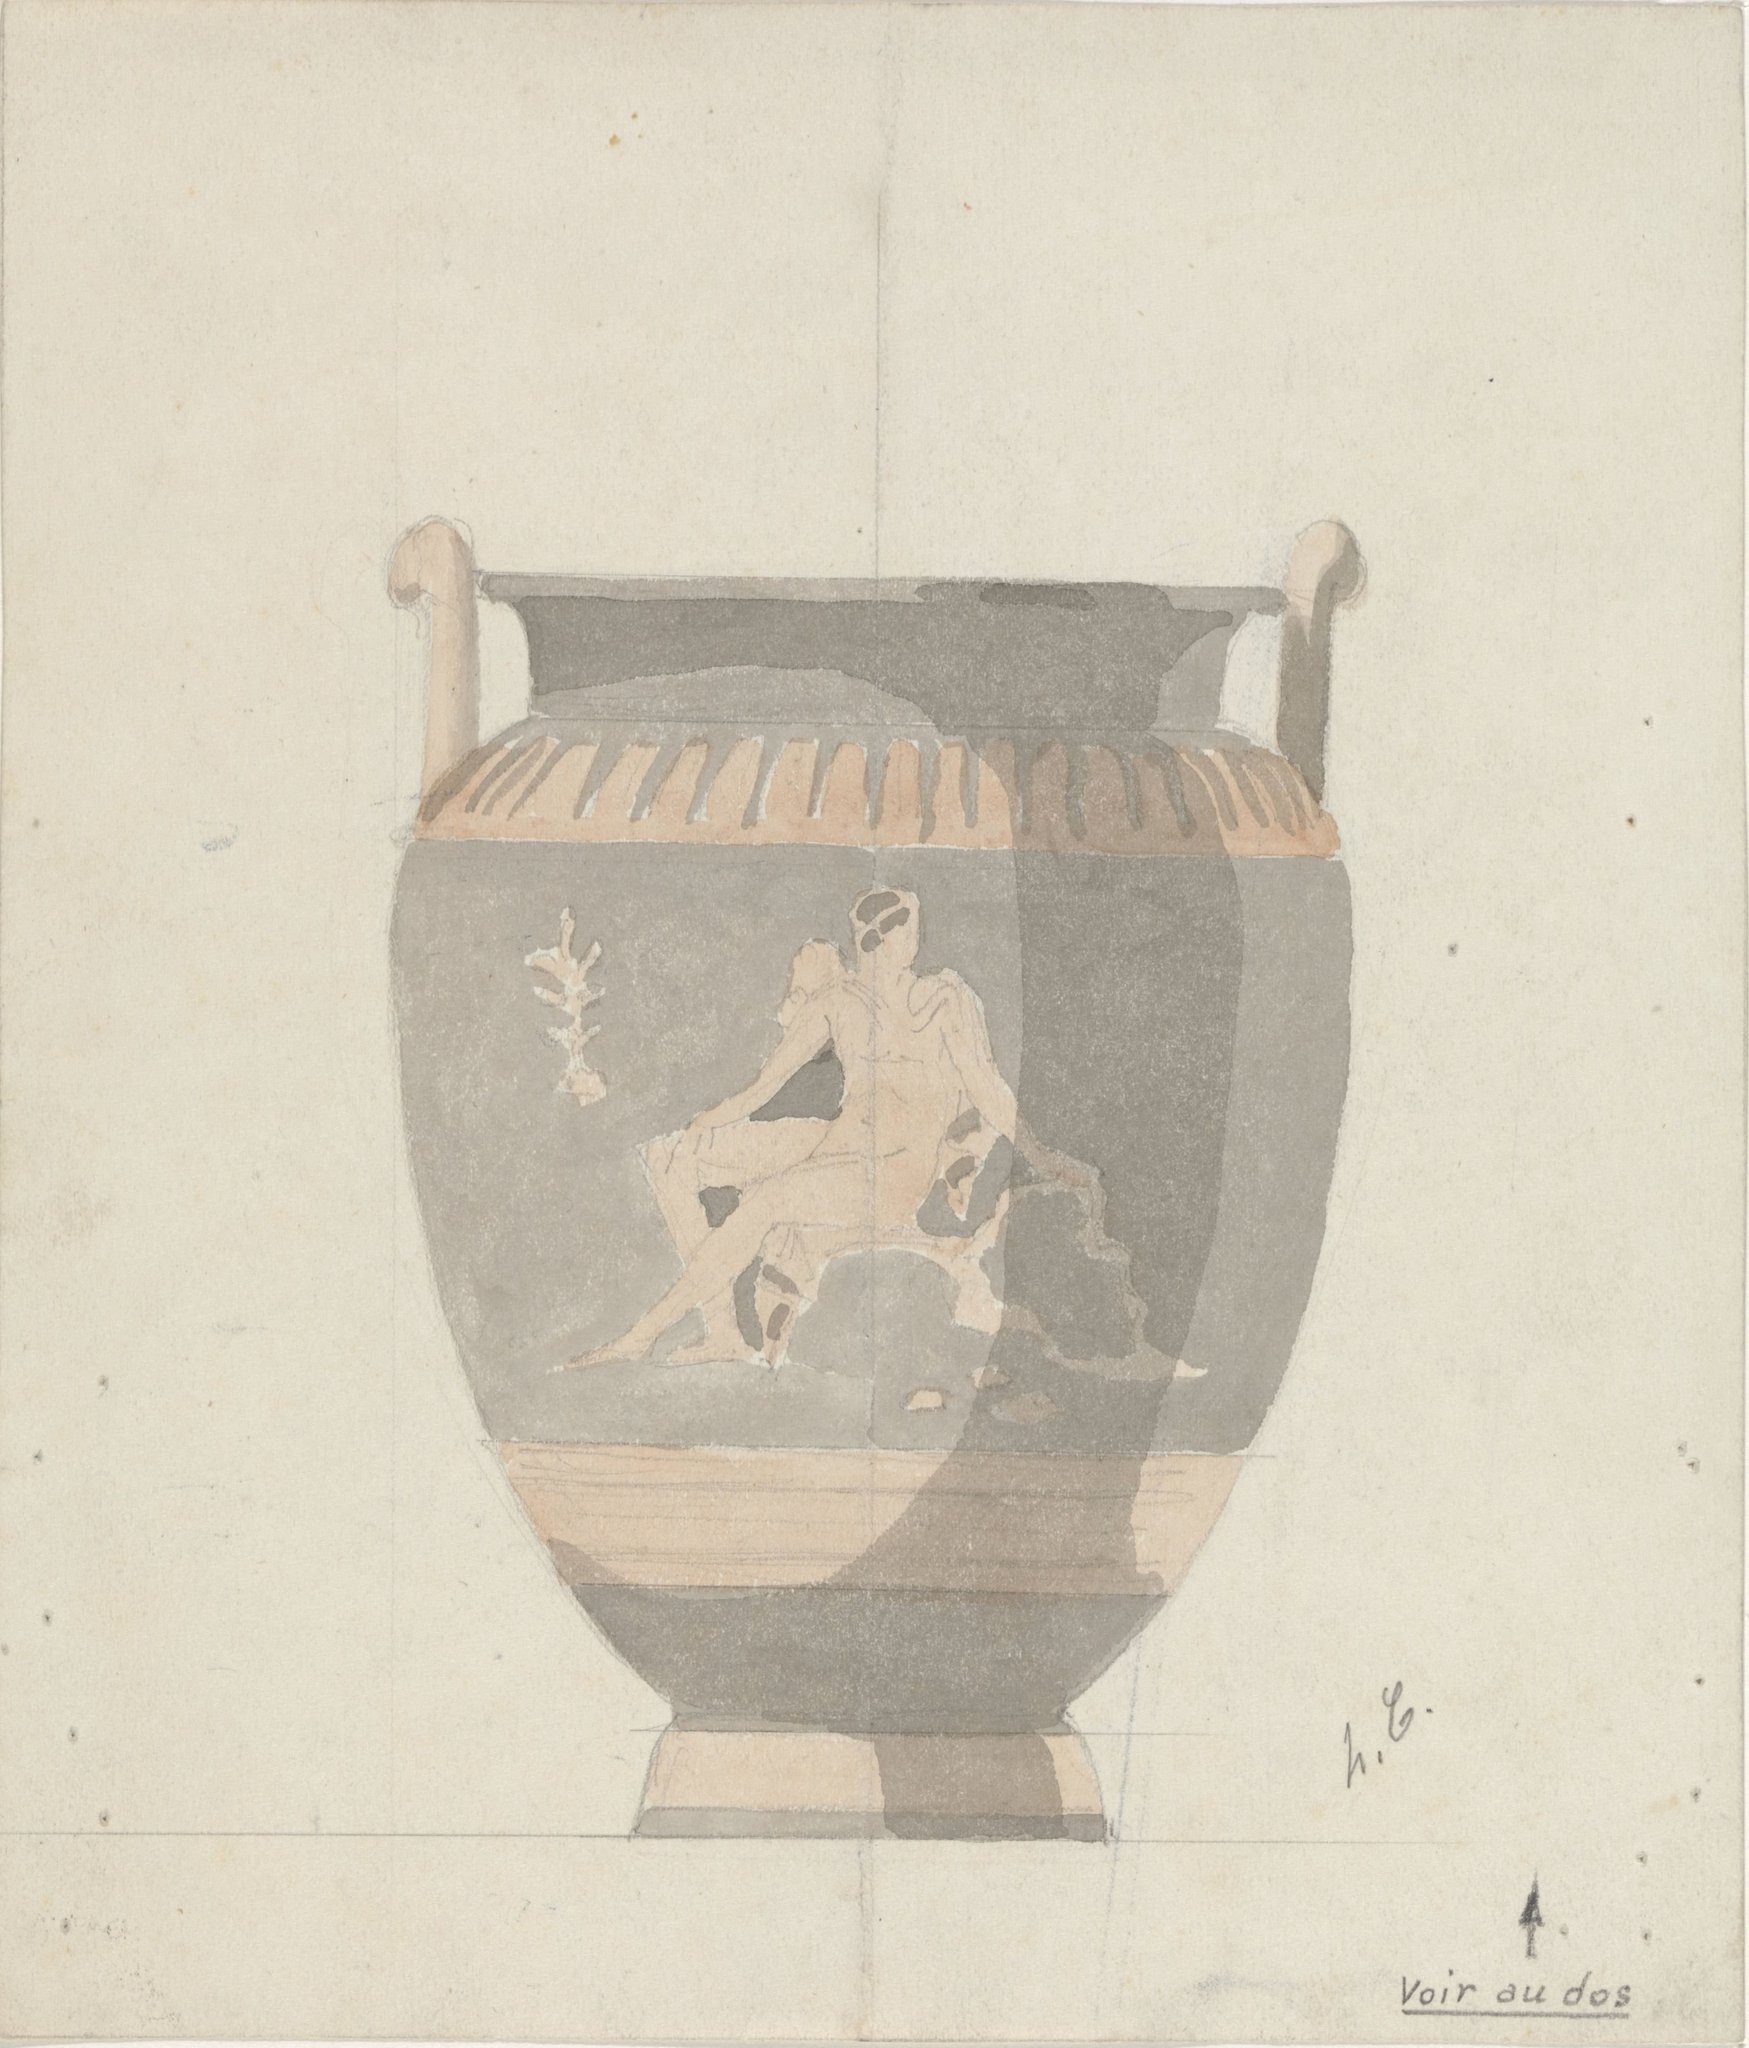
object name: design drawing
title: Ontwerp voor vaas in Griekse stijl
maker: henri cameré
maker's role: designer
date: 1864-1894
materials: paper, pencil, watercolor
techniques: brush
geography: paris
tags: container of ceramics: jar, jug, pot, vase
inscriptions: signature: ‘h.C.’